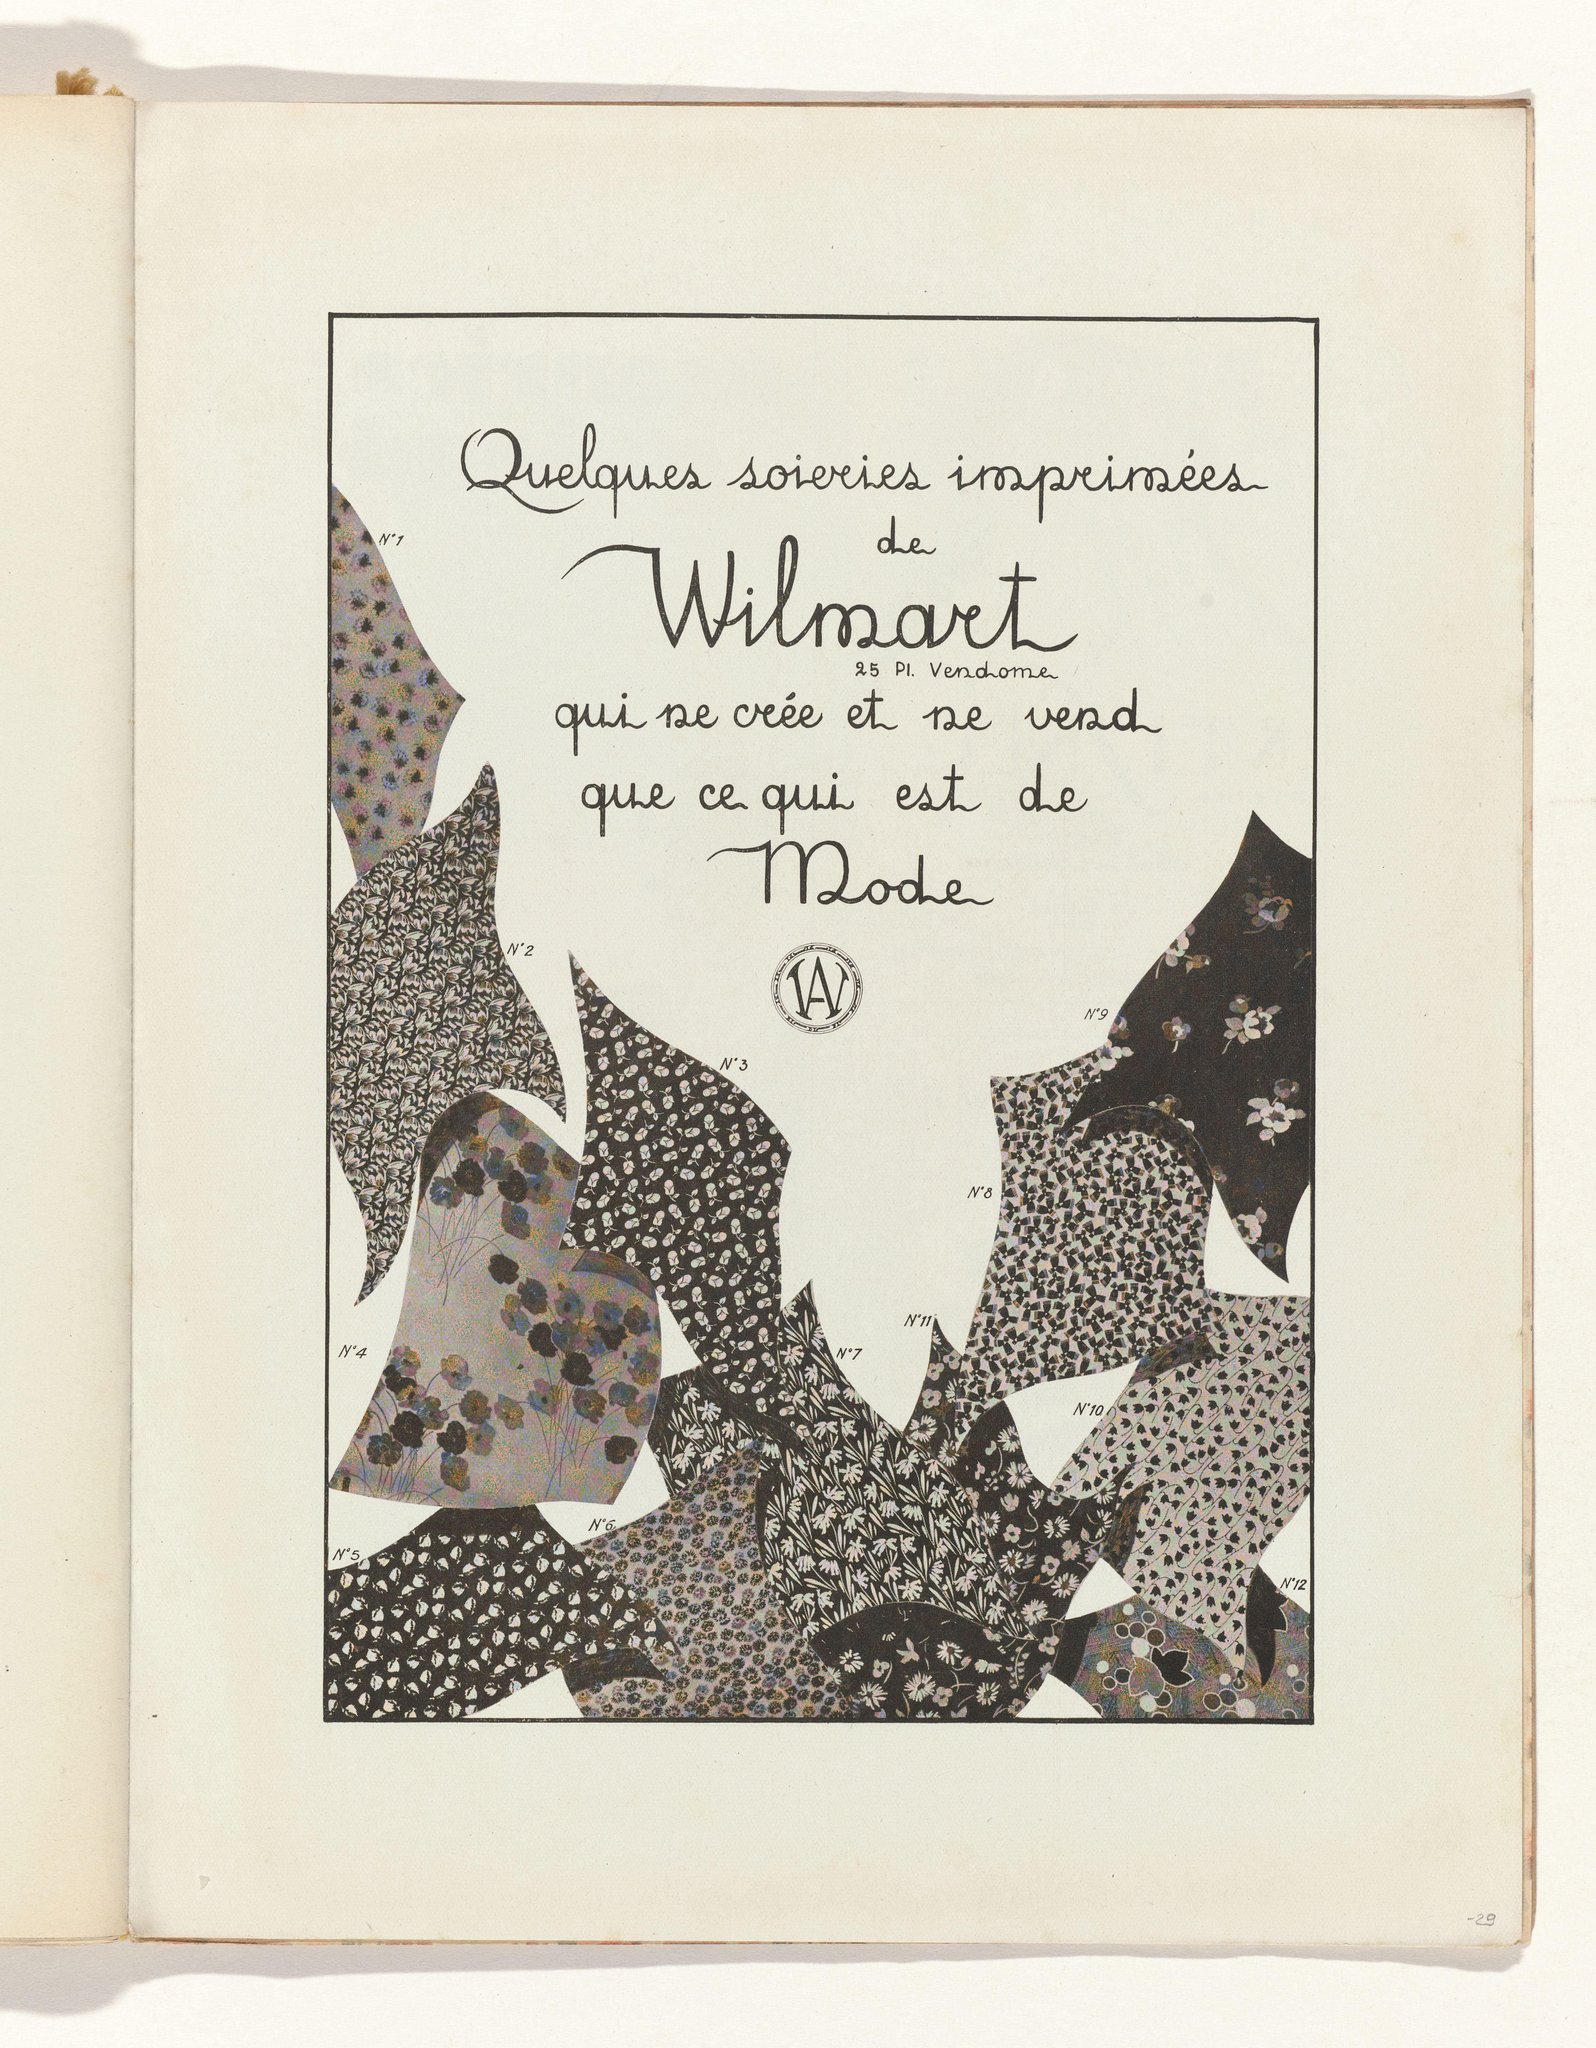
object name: fashion print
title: Art - Goût - Beauté, Feuillets de l' élégance féminine, Mai 1929, No. 105, 9e Année, p. 30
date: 1929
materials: paper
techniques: photography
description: Advertentie stoffen Wilmaert. Pagina uit het modetijdschrift Art-Goût-Beauté (1920-1933).